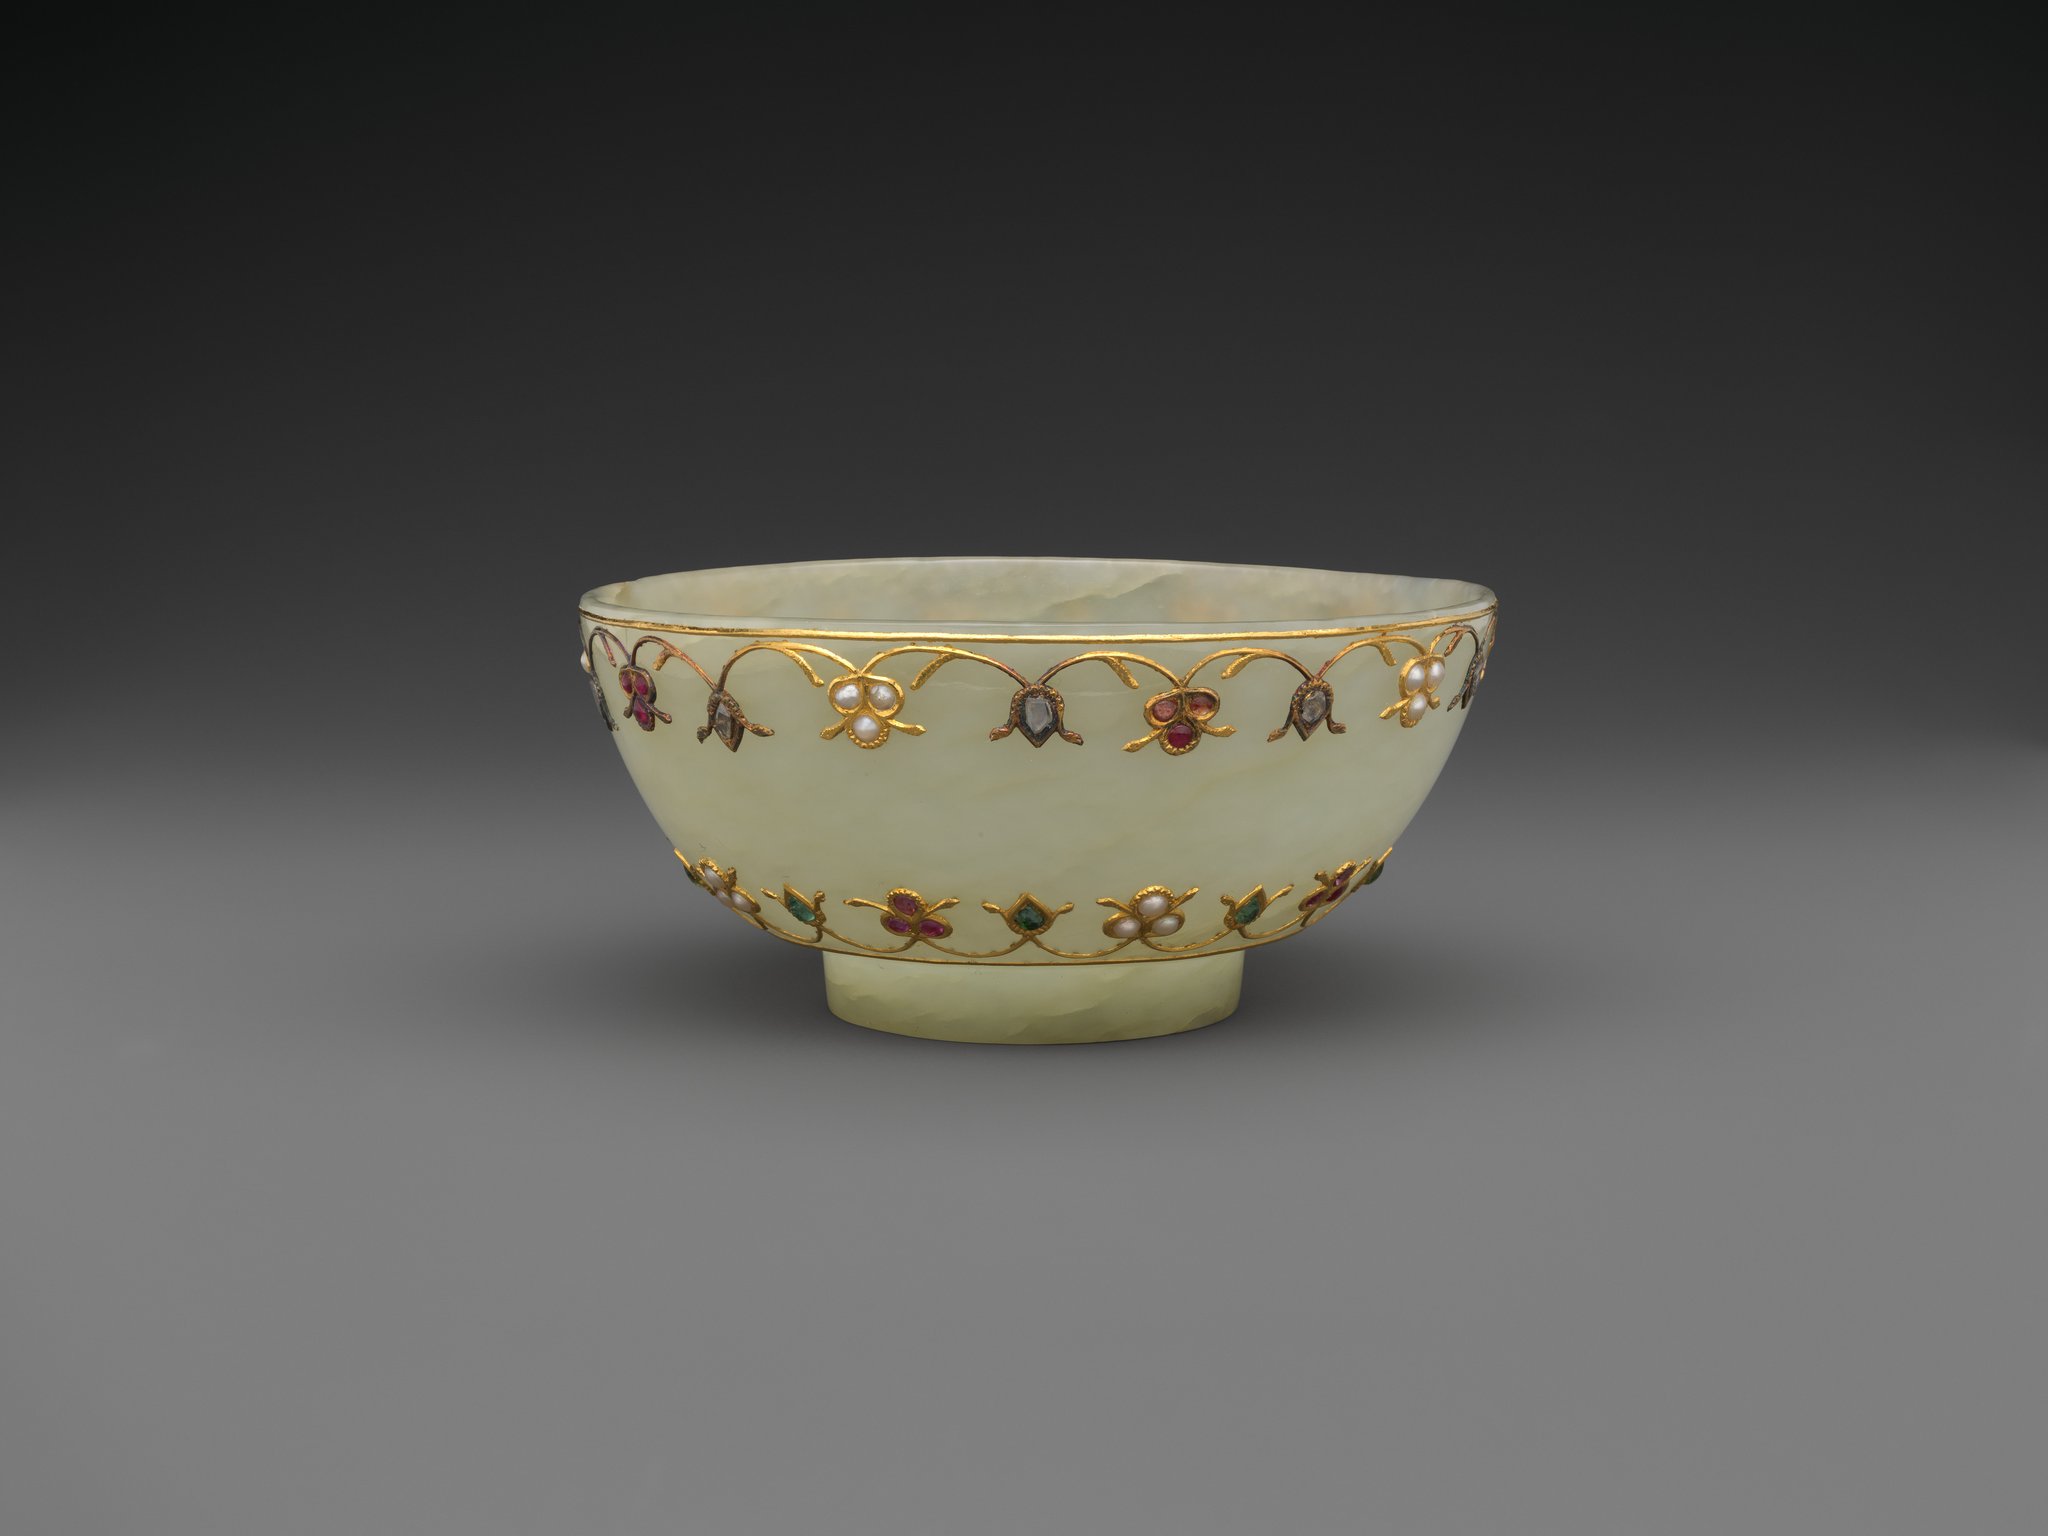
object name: bowl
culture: indian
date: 1701-1900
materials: gold, jade, stone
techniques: inlay